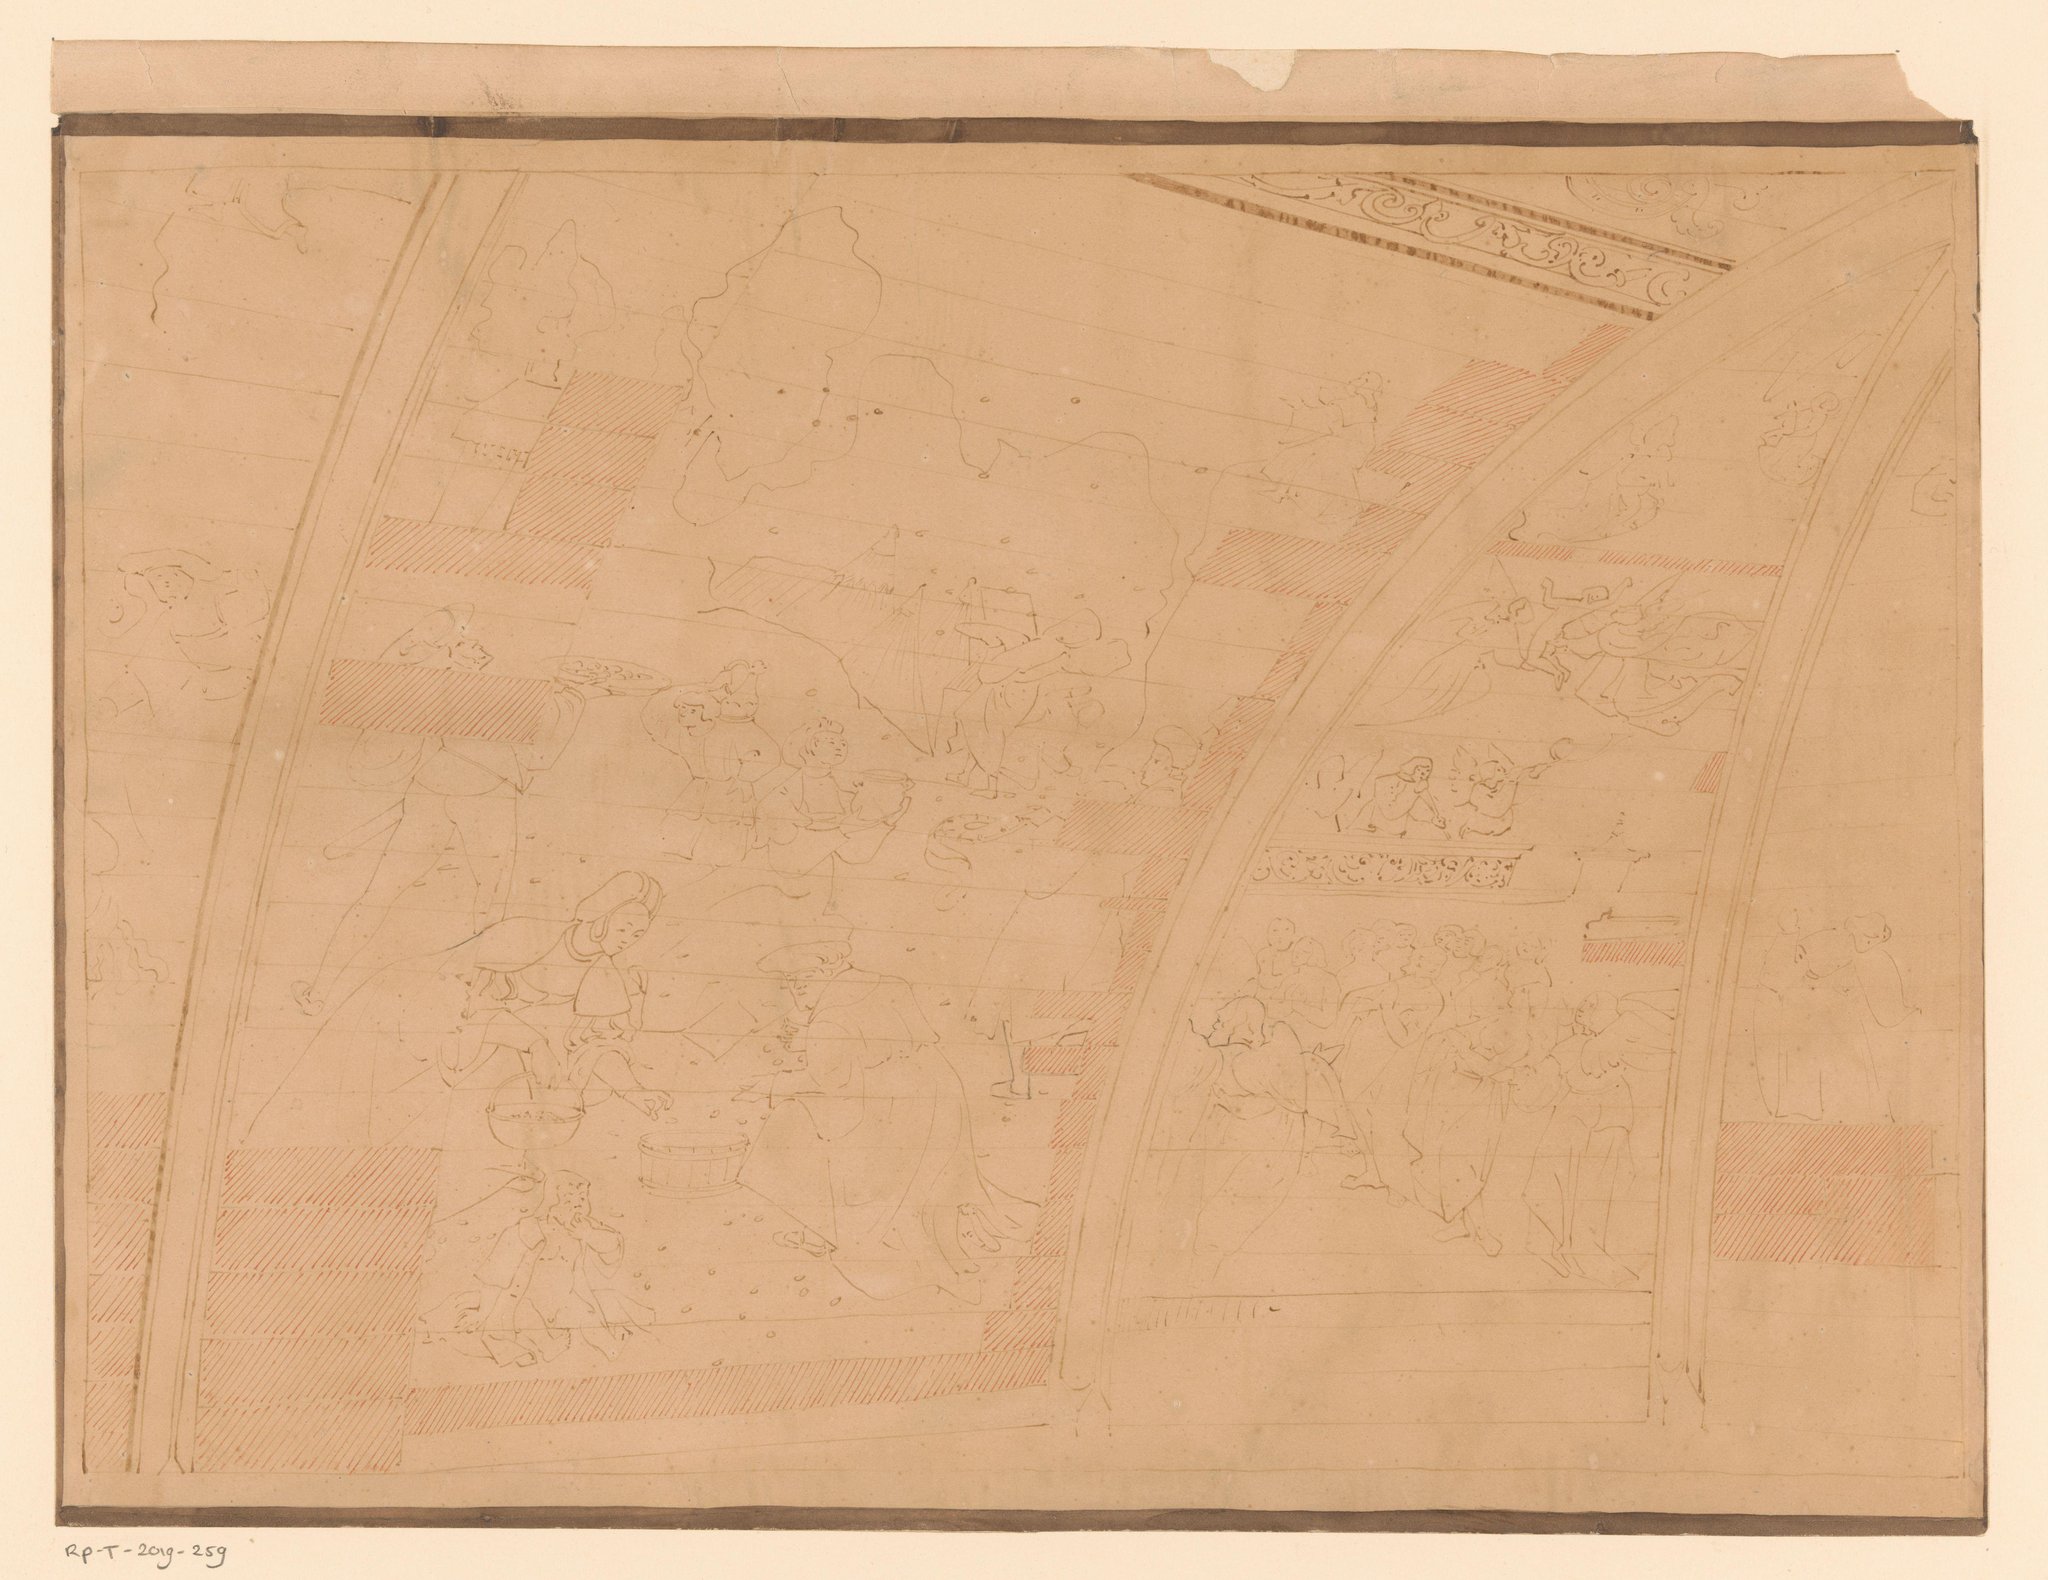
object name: drawing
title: Mannaregen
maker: Anonymous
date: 1890-1950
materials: ink, paper, pencil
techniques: brush, pen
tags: interior ~ architectural design or model, (decorated) ceiling, old testament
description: Rond 1525 is het gewelf in het koorgedeelte van de Ursulakerk te Warmenhuizen voorzien van renaissancistische schilderingen, waarschijnlijk vervaardigd door Jacob Cornelisz. van Oostsanen. Zij stellen het Laatste Oordeel en een viertal Oudtestamentische verhalen voor. In 1891 zijn ze overgebracht naar het Rijksmuseum, maar na de grote kerkrestauratie rond 1960 weer in de kerk teruggeplaatst.